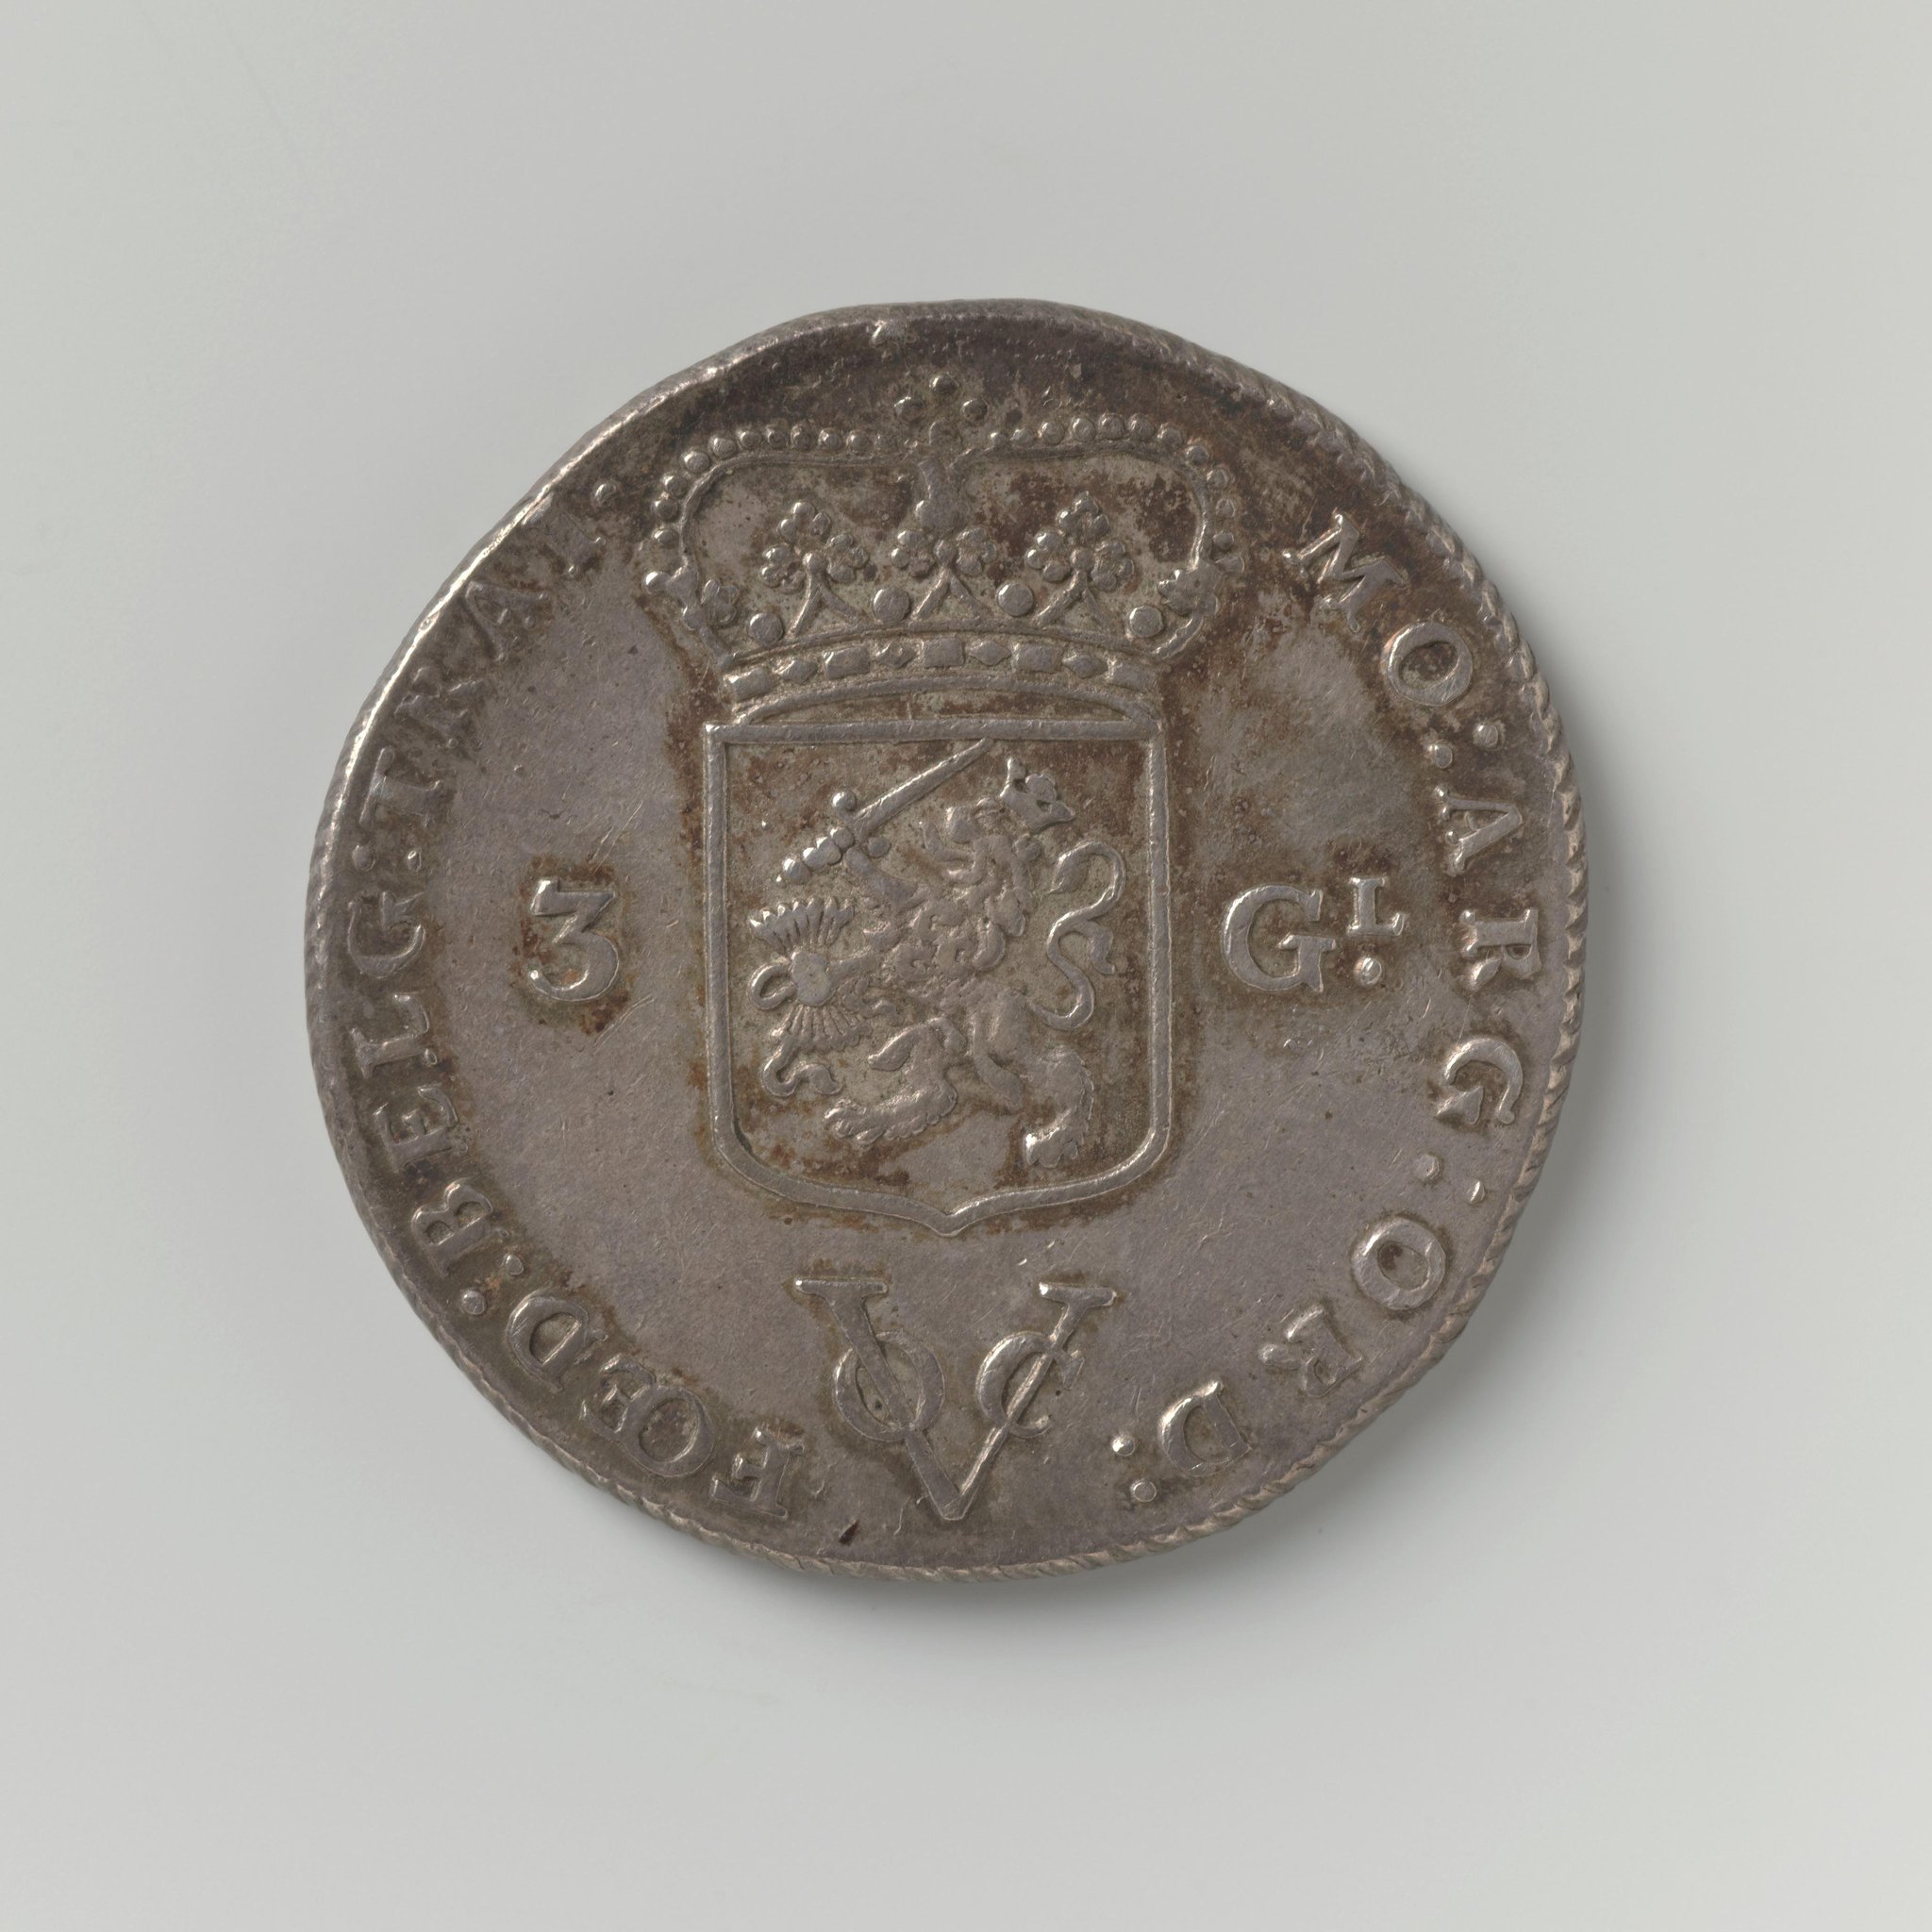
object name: coin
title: VOC, drie gulden, Utrecht, 1786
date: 1786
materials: silver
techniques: striking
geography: utrecht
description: Zilveren munt. Voorzijde: tussen waarde-aanduiding 3 Gl. gekroond generaliteitswapenschild, waaronder monogram van de VOC. Keerzijde: Nederlandse maagd met speer, waarop vrijheidshoed, leunend op een bijbel op een altaar. Jaartal in afsnede. Kabelrand.